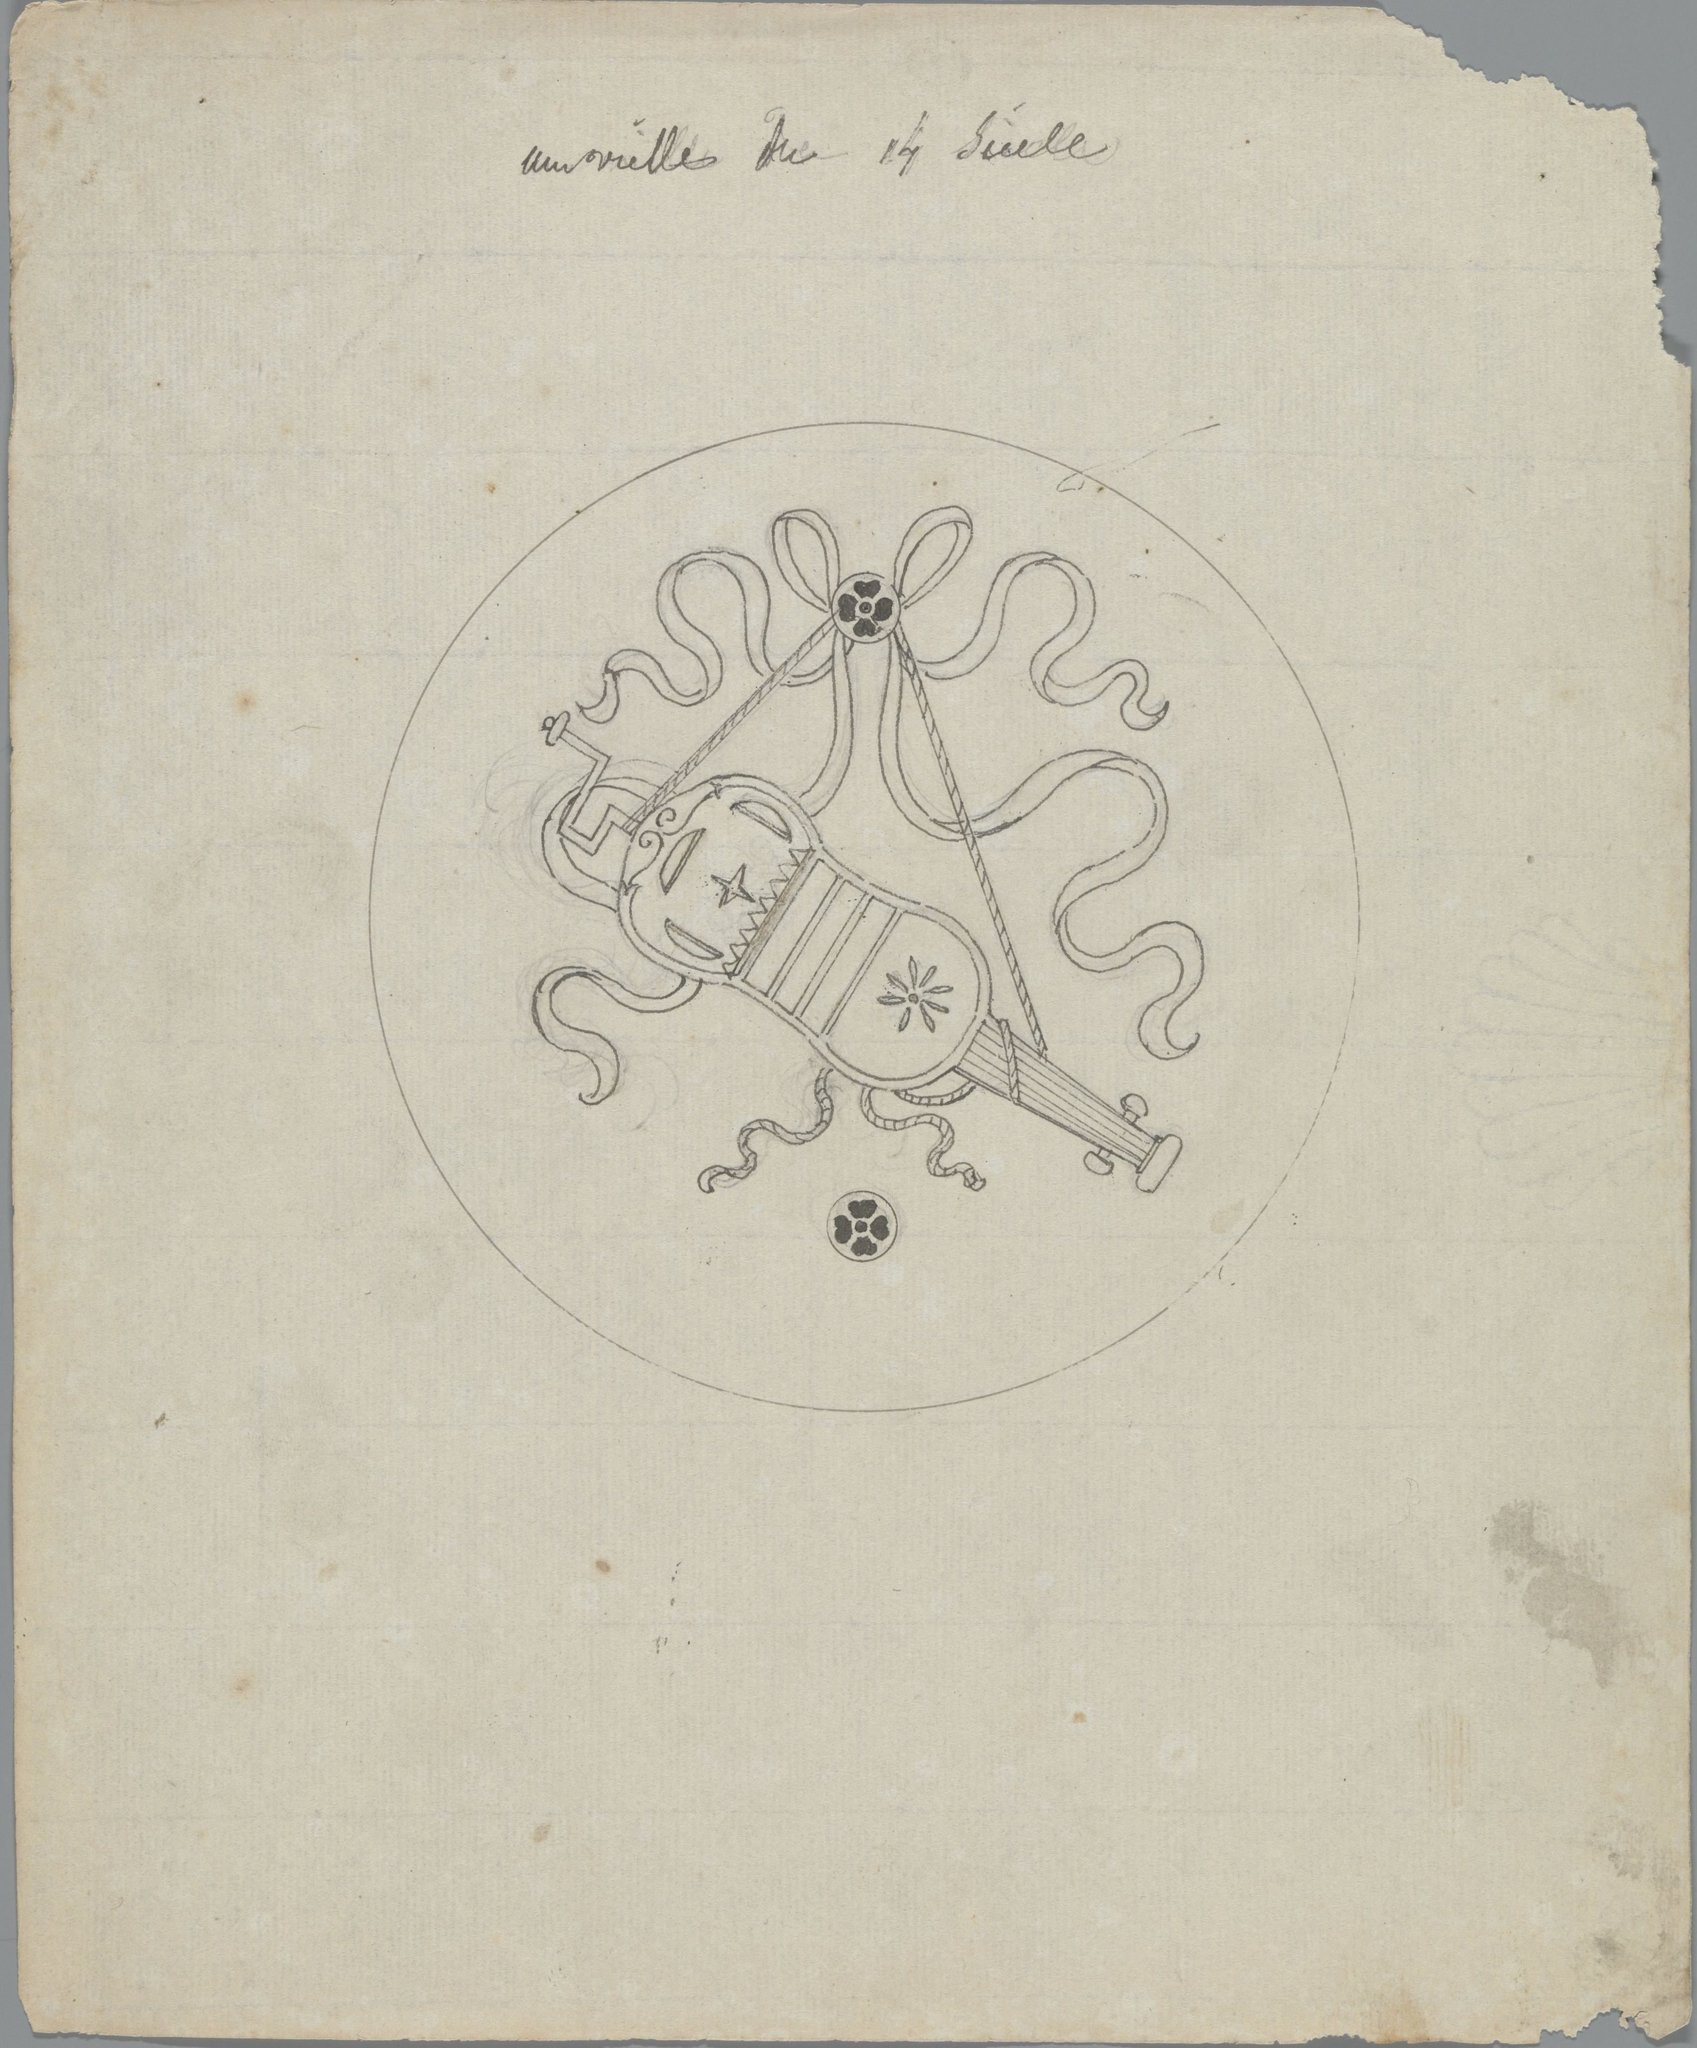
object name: design drawing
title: Ontwerp voor marqueterie van aan linten opgehangen muziekinstrument(en) in rond medaillon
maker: pierre félix van doren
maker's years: 1797-1856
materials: graphite, ink, paper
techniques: pen in black ink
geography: brussels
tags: trophy, i.e.: decorative arrangement of symbolic or typical objects ~ ornament, string instruments (bowed)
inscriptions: inscription: ‘une vielle du 14 siècle’, watermark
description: Een van 103 ontwerpen voor marqueterie van aan linten opgehangen muziekinstrumenten in ronde medaillons, bestemd voor de set stoelen gemaakt door Van Doren voor de grote zaal van het Paleis van de Prins van Oranje in Brussel in 1828.